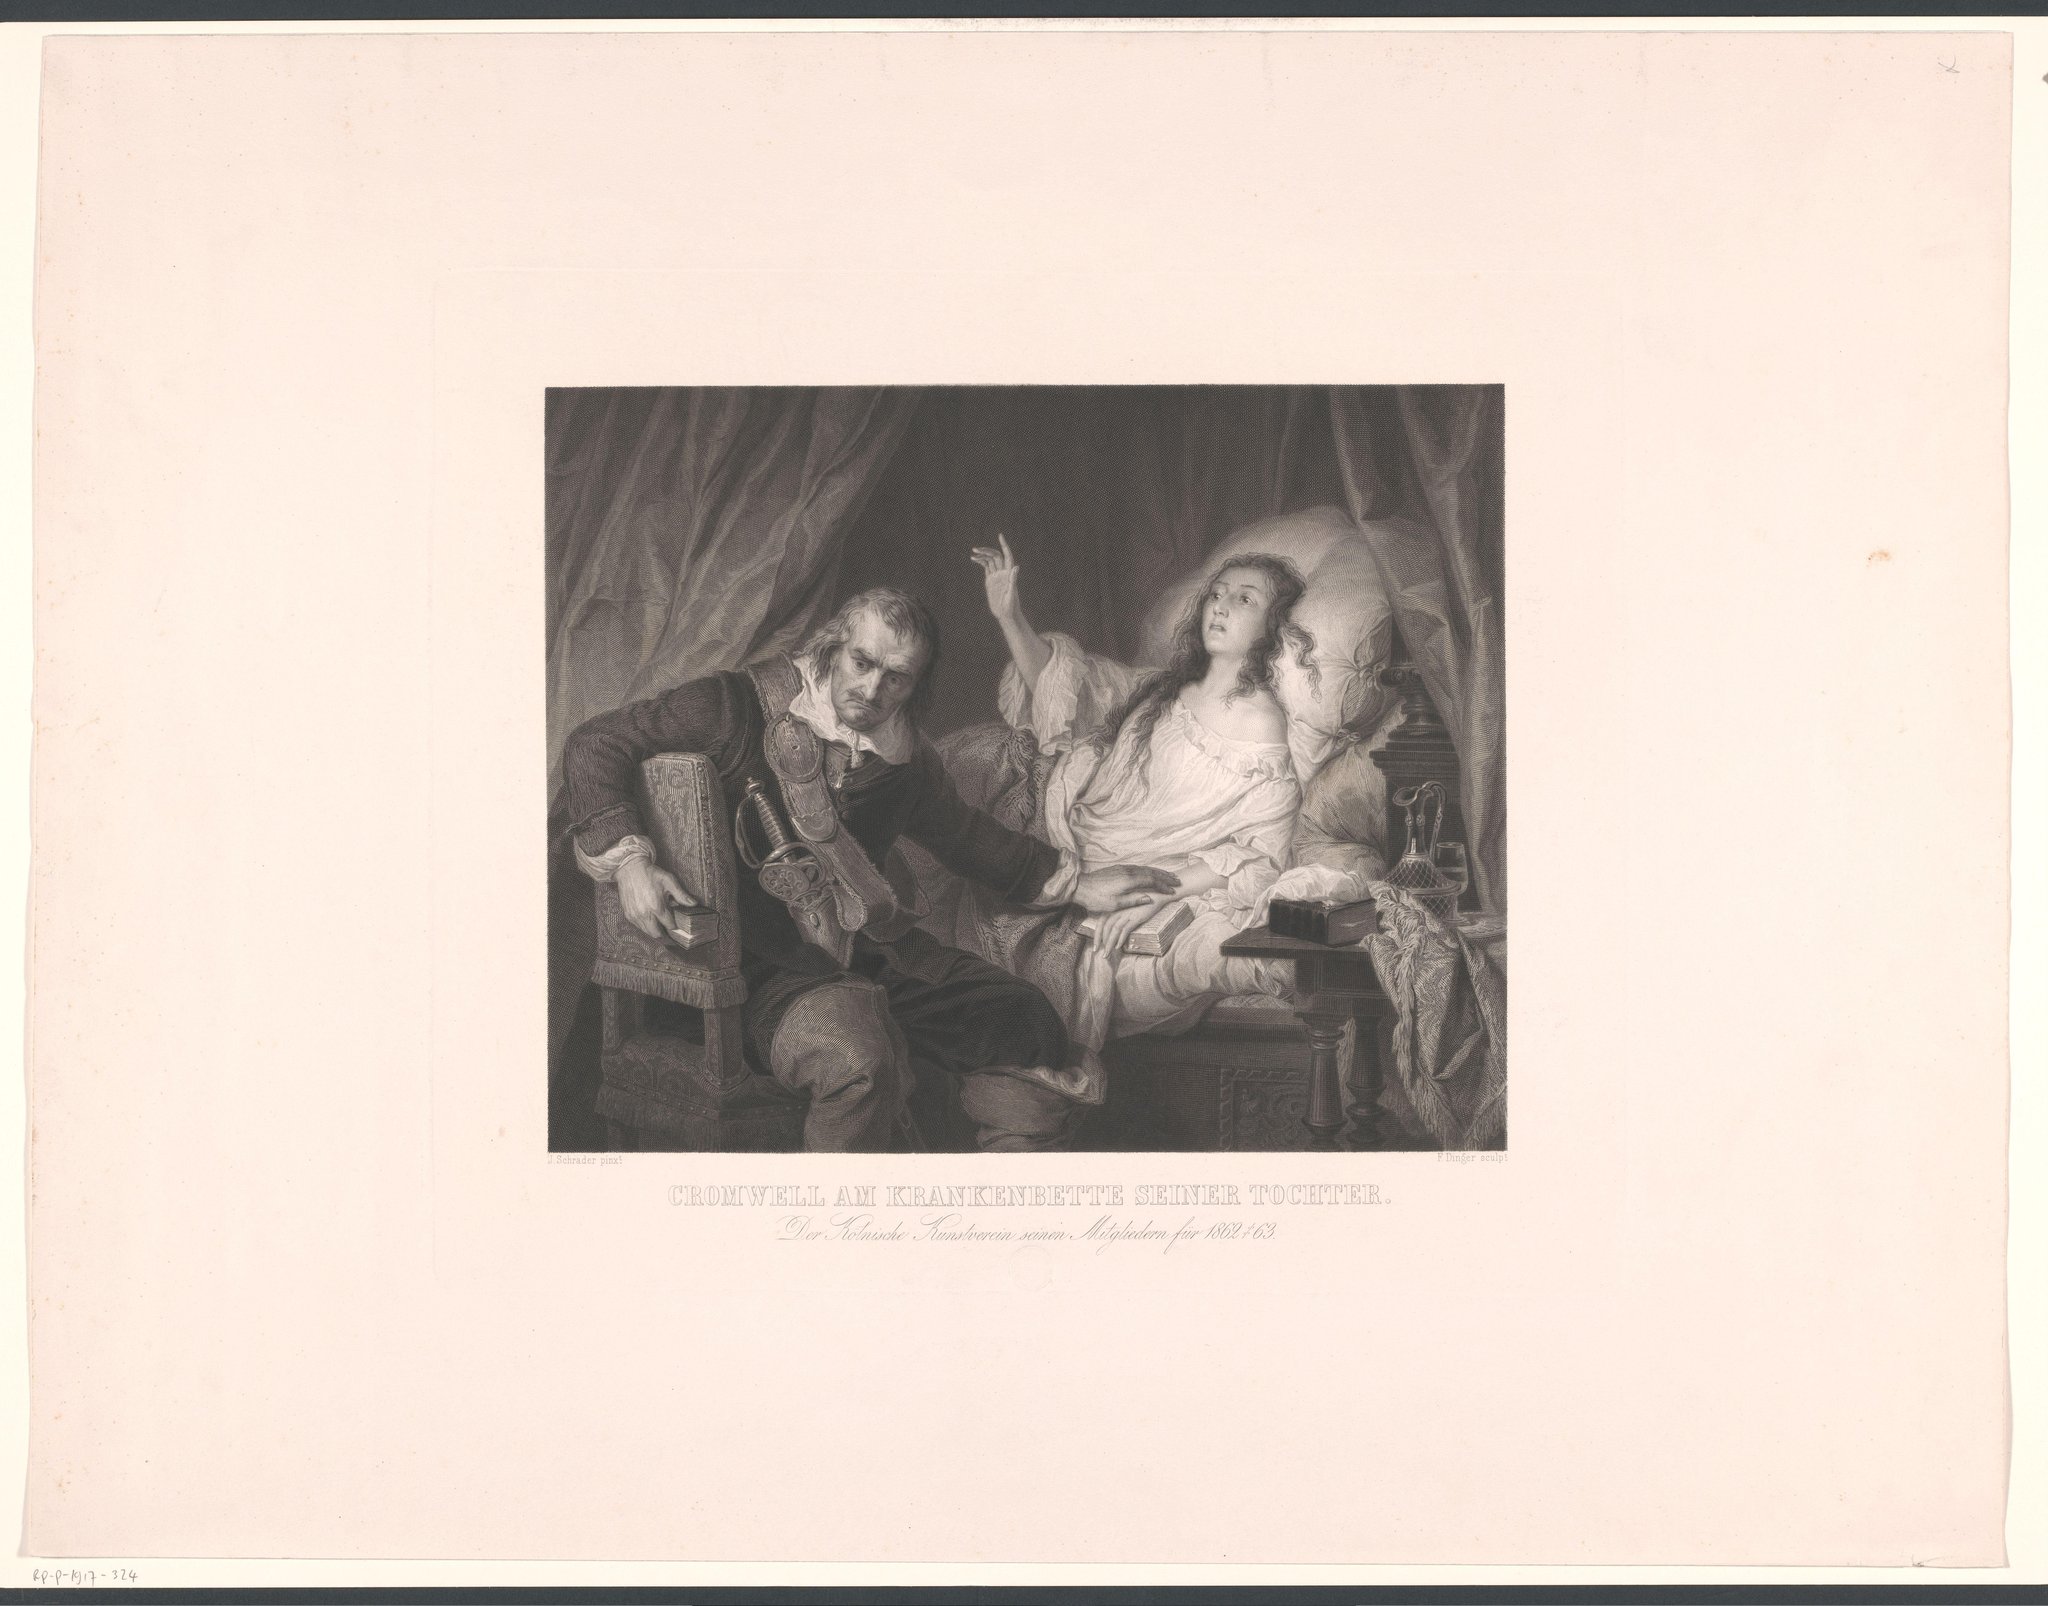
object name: print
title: Oliver Cromwell bij het sterfbed van zijn dochter Elizabeth Claypole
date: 1863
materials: paper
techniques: engraving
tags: london, oliver cromwell, historical persons - bb - woman, deathbed, historical persons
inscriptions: collector's mark: Lugt 2228